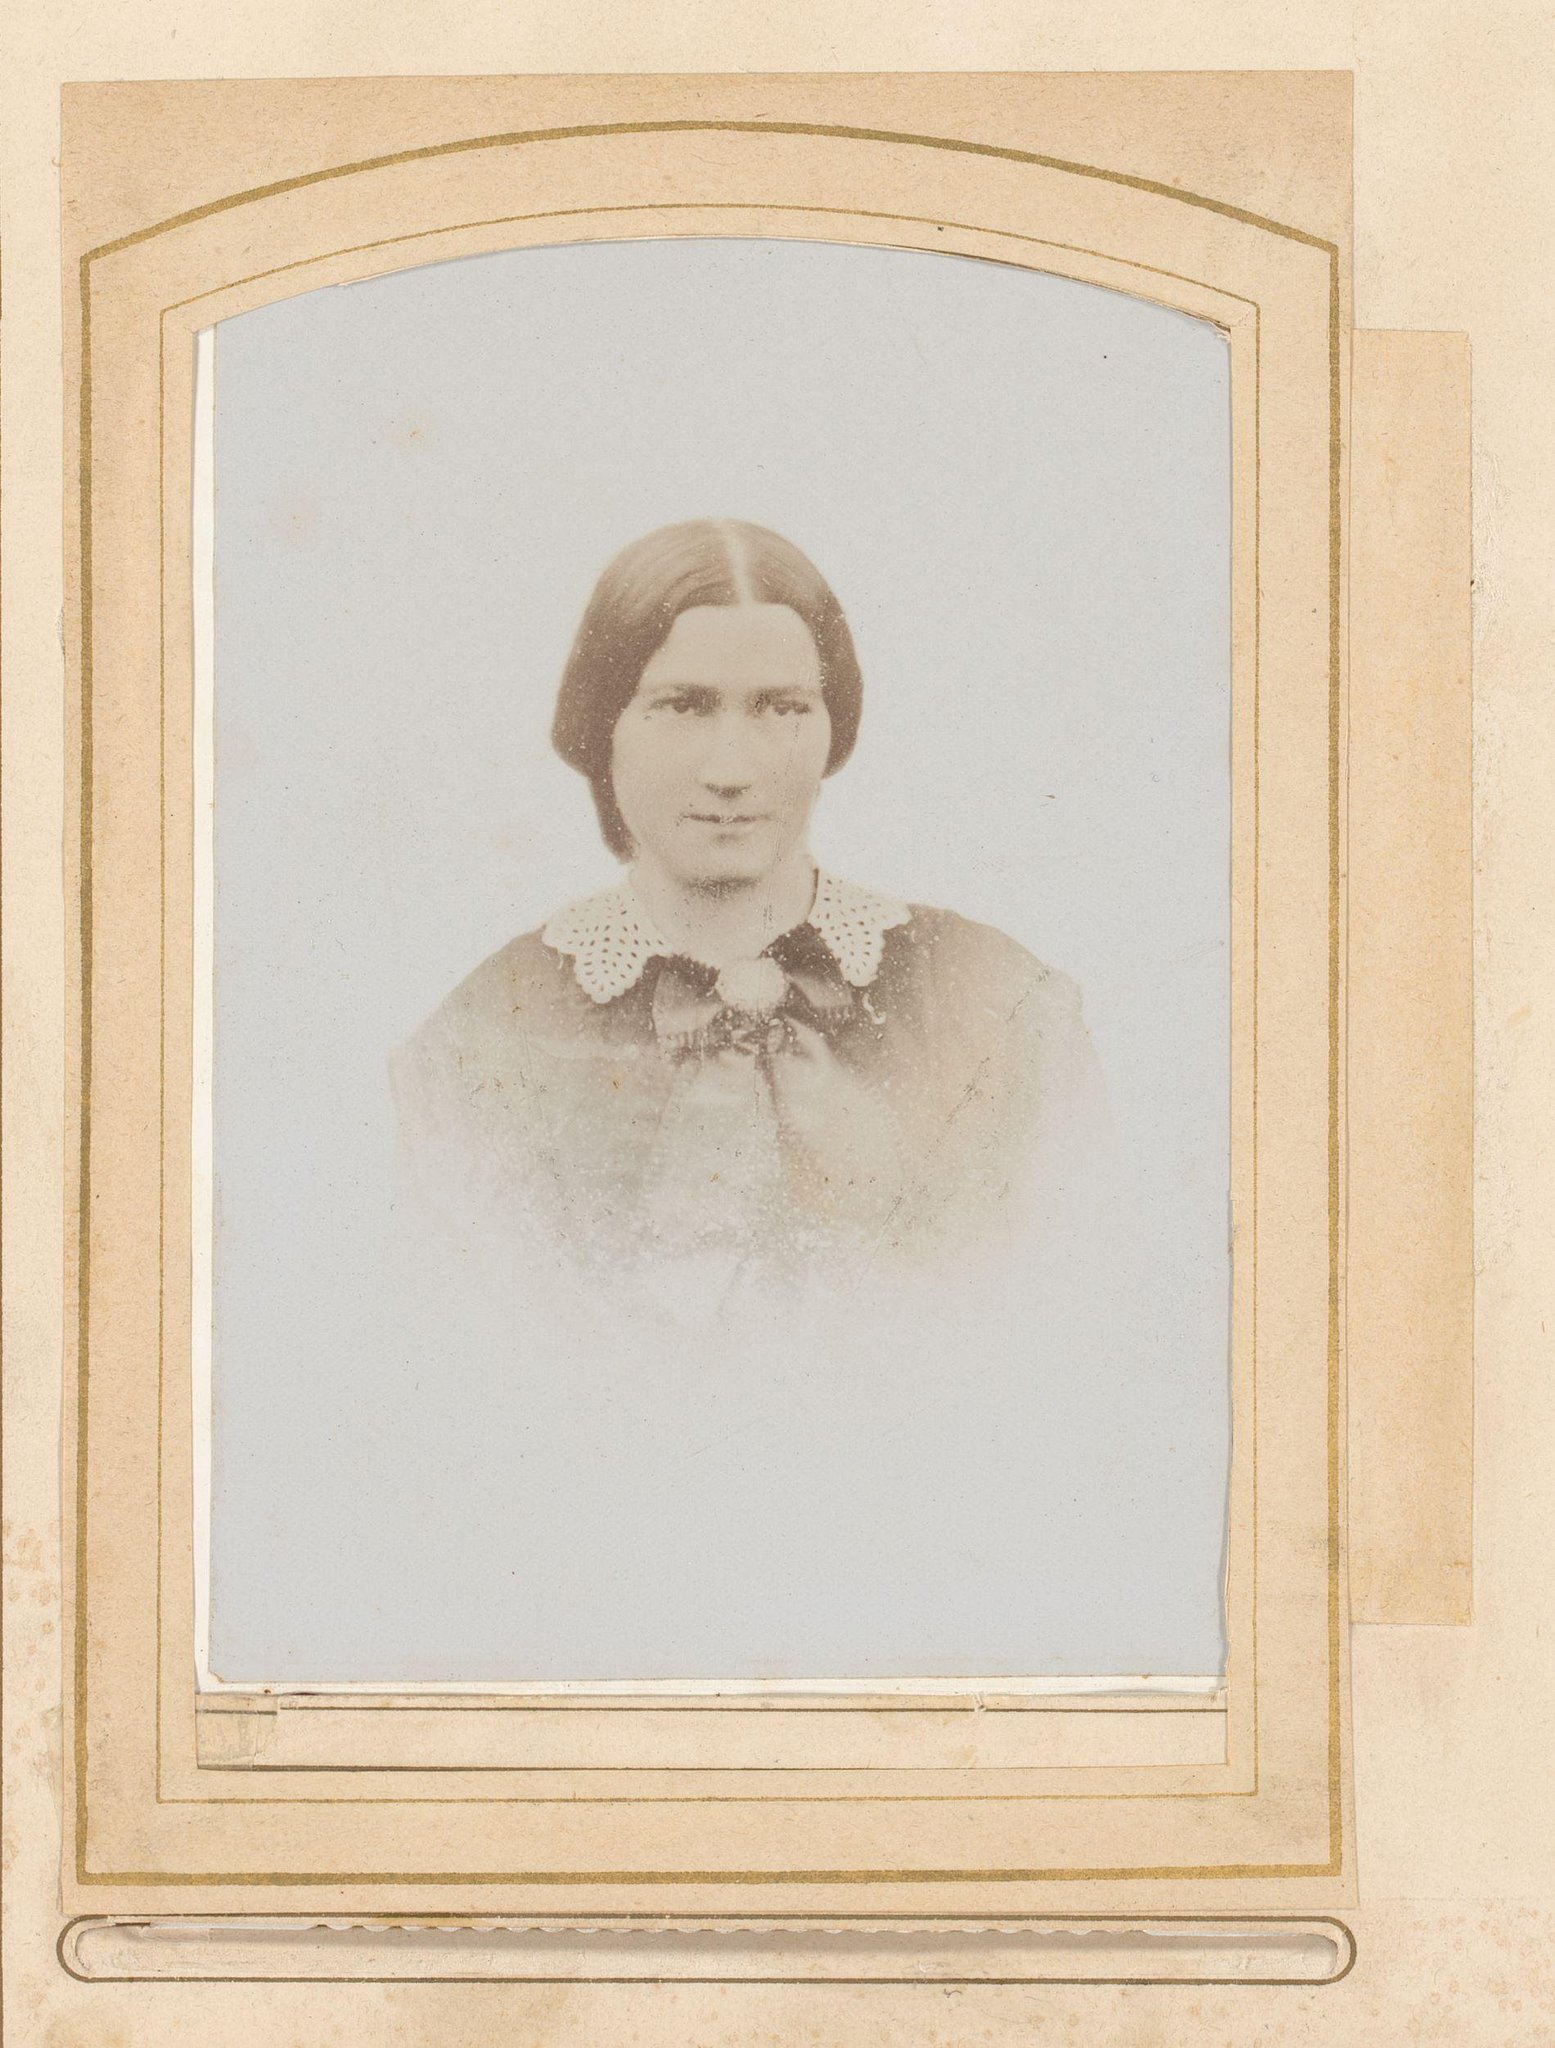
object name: album leaf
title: Portret van een vrouw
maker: Anonymous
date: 1890-1900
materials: cardboard, photographic support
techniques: gelatin silver print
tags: historical persons - bb - woman